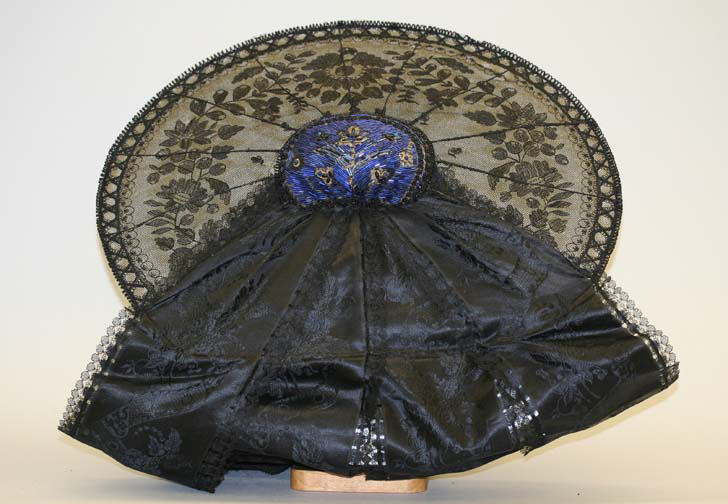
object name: headdress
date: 1701-1900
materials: silk